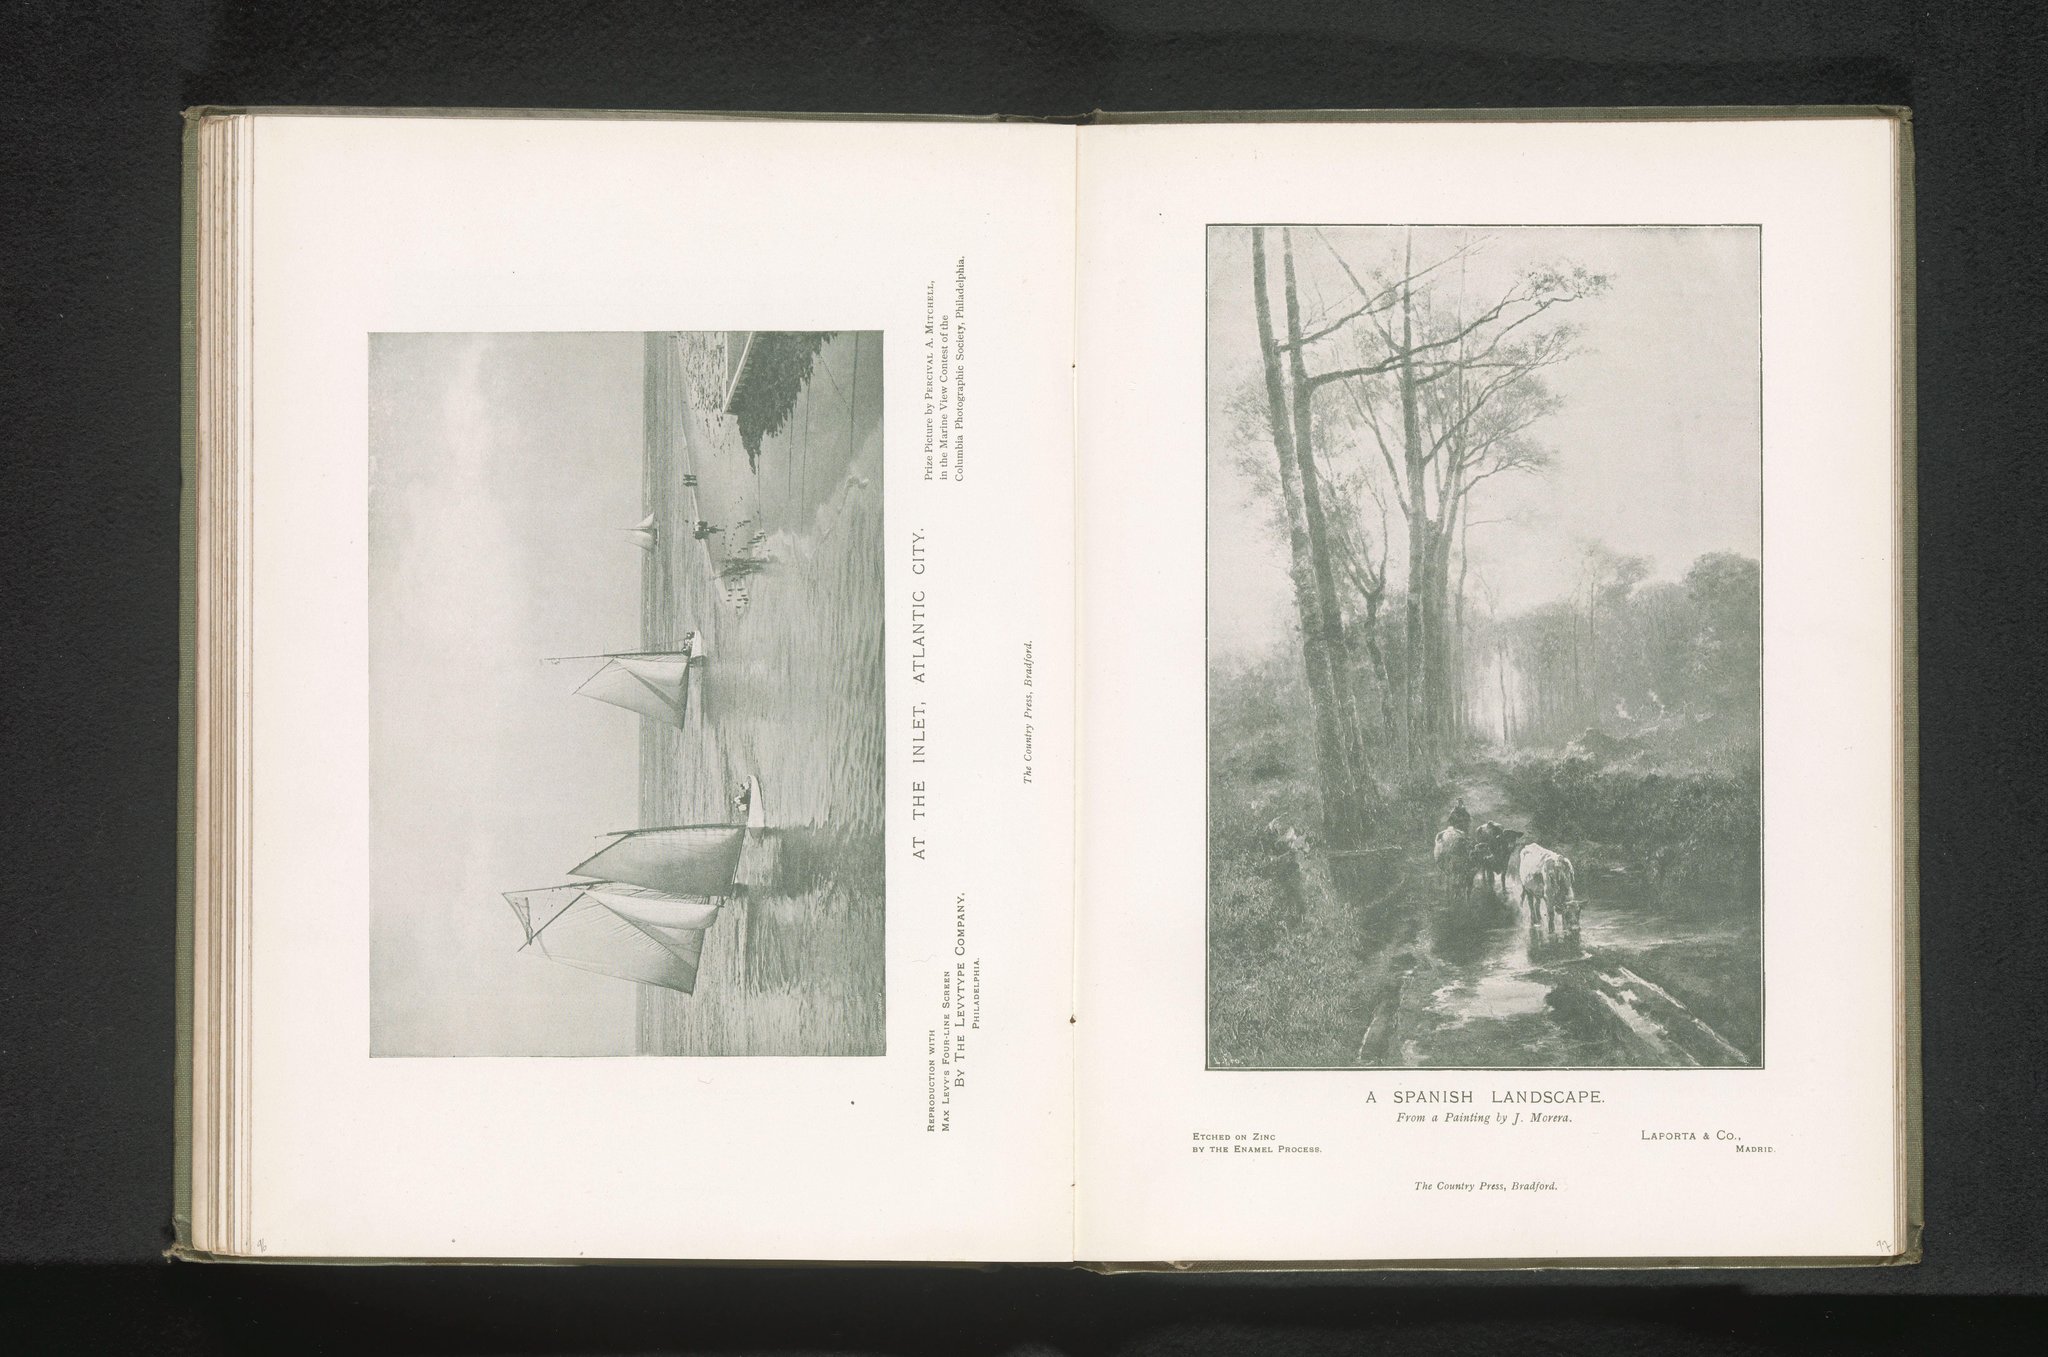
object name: reproduction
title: Reproductie van een geschilderd landschap met koeien door J. Morera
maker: jaime morera y galicia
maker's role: painter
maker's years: 1854-1927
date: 1893-1898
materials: paper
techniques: autotype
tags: cattle, forest, wood (+ landscape with figures, staffage)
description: Prent op zevende ongenummerde pagina na pagina 108.